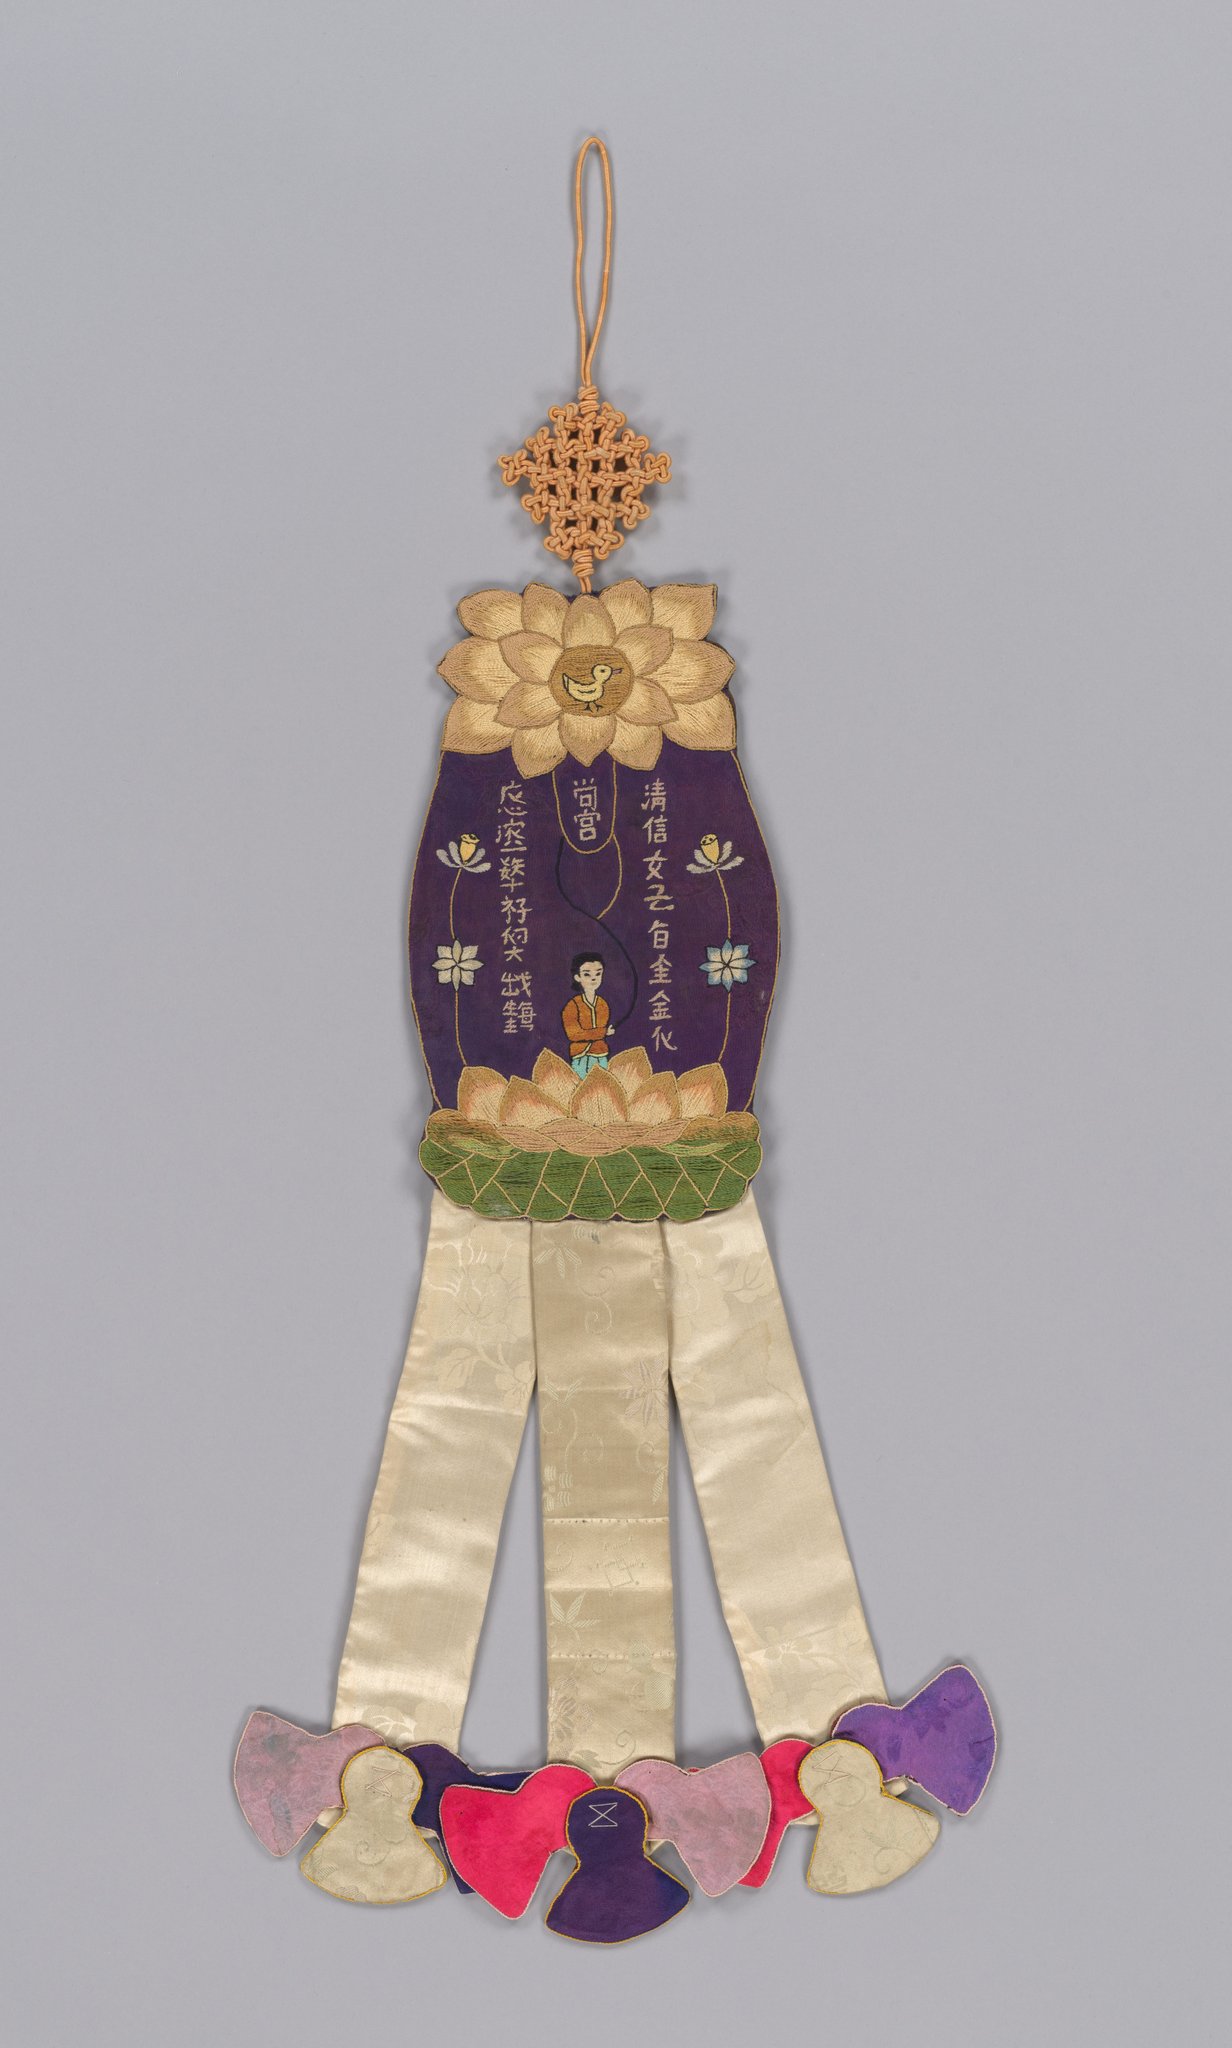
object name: pouch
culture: korean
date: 1867-1933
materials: silk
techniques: embroidery